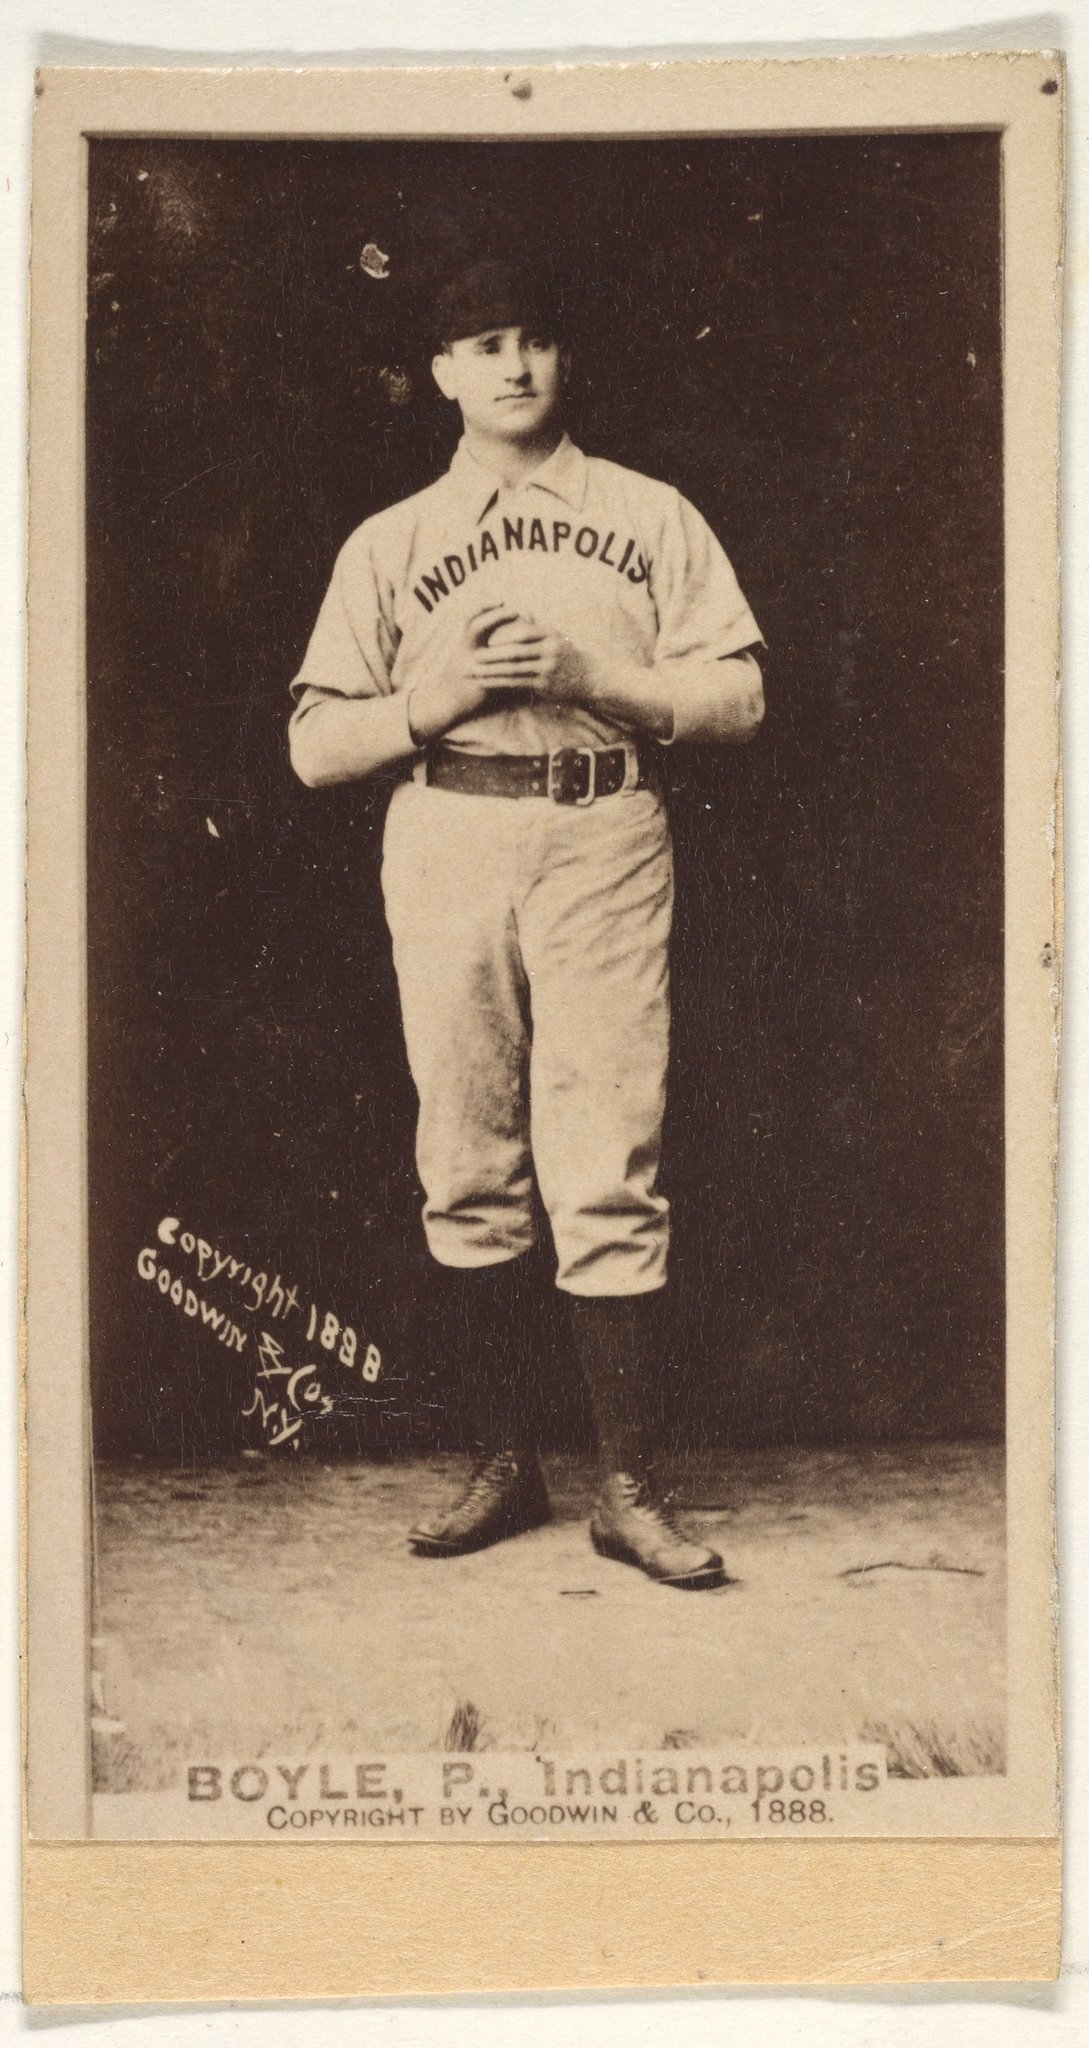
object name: baseball card, photograph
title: Boyle, Pitcher, Indianapolis, from the Old Judge series (N172) for Old Judge Cigarettes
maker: goodwin & company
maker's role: publisher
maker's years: 1850-1950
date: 1888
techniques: albumen silver print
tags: men,portraits,baseball,athletes